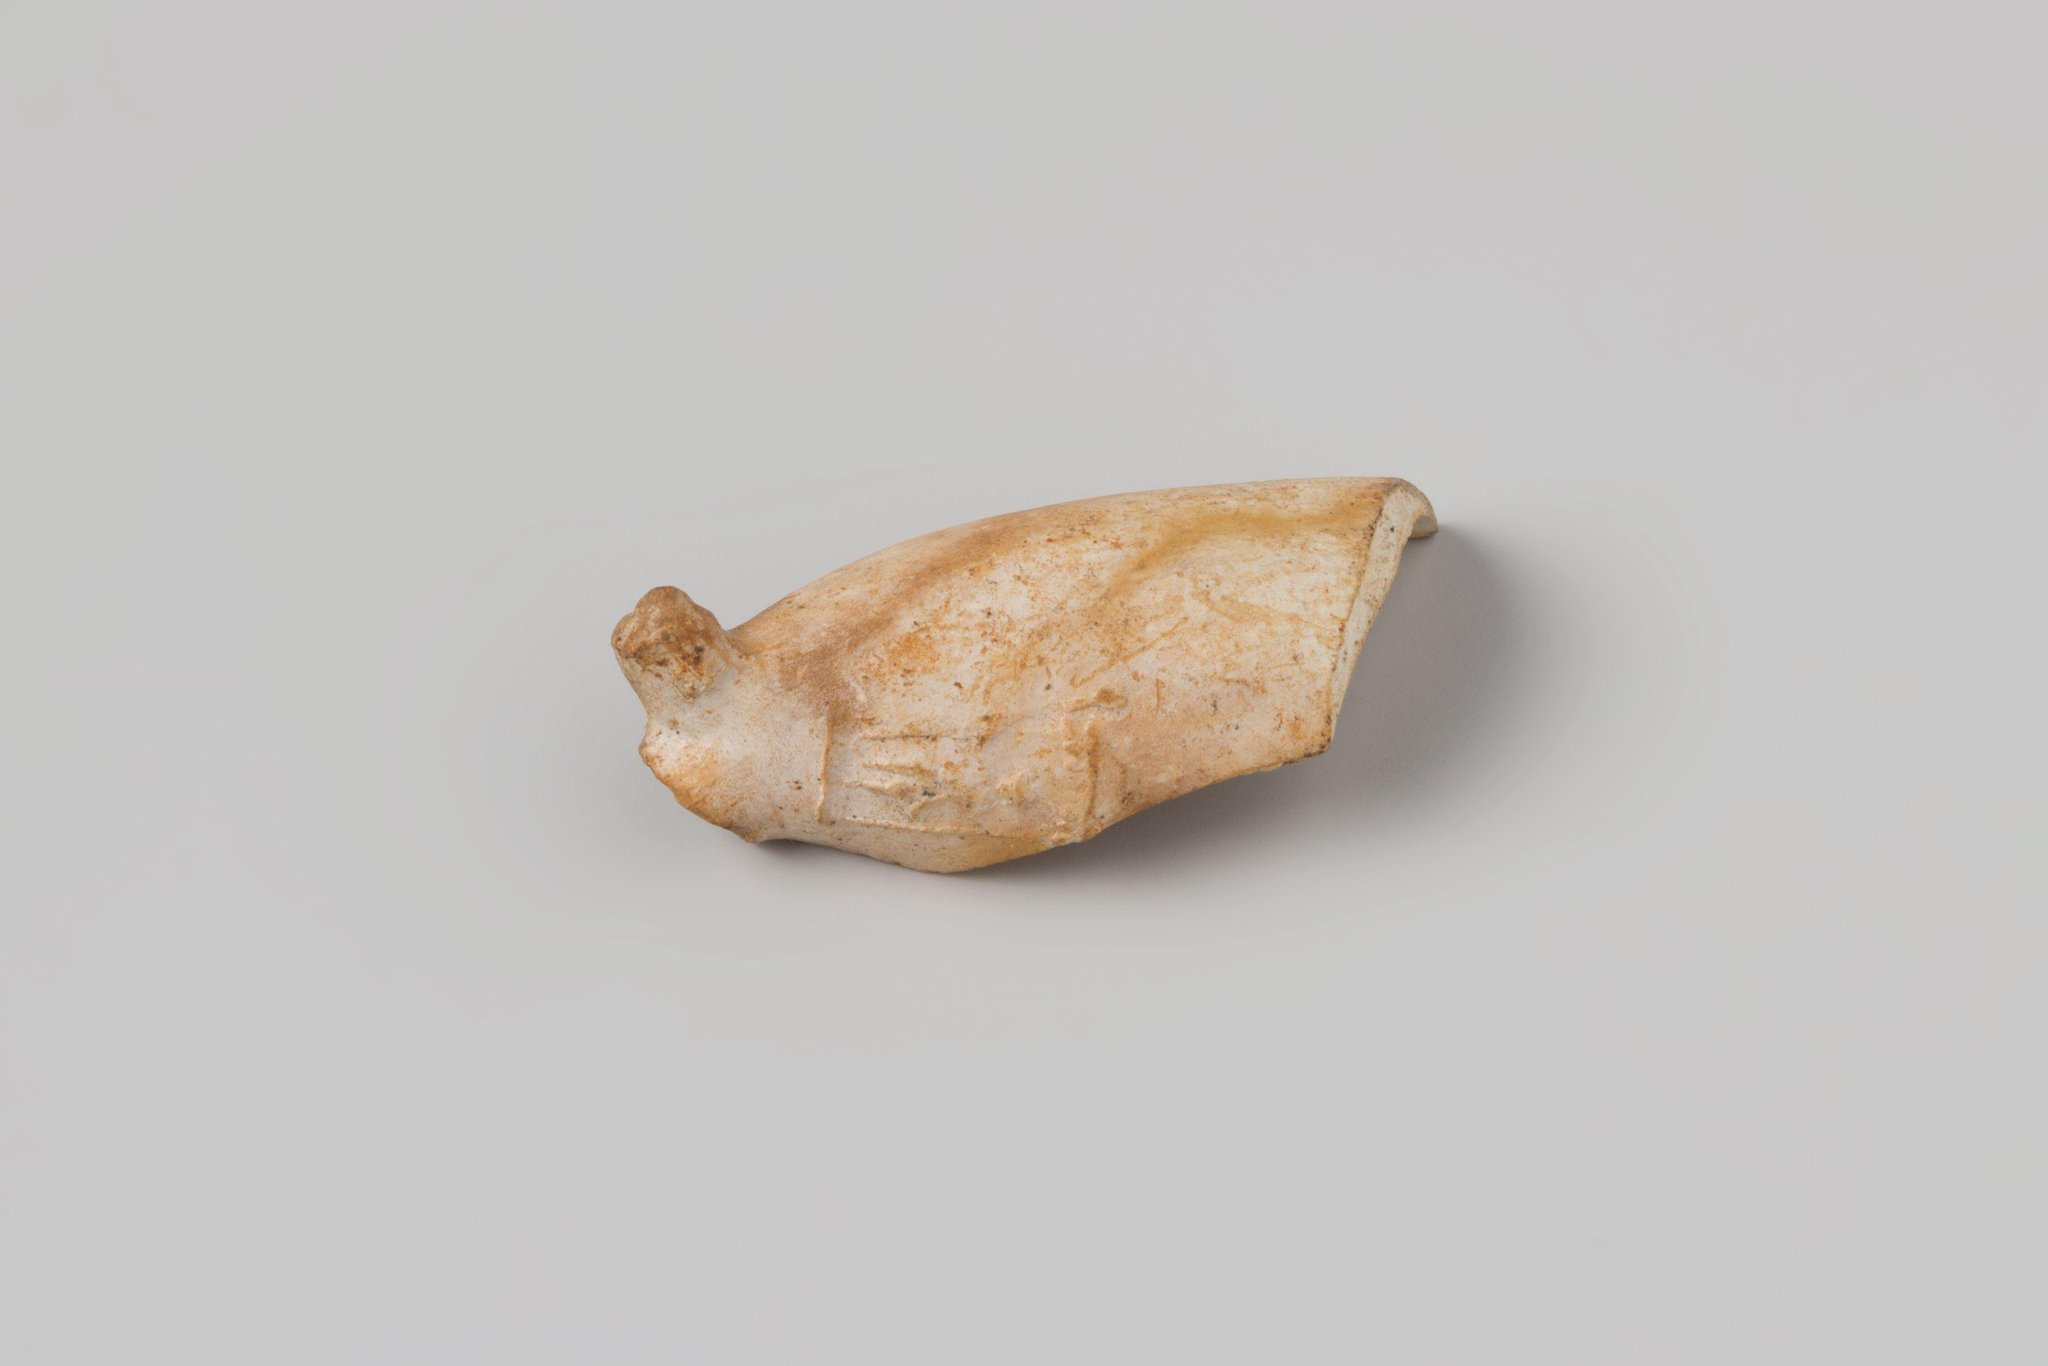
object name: pipe bowl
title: Fragment pijpenkop uit het wrak van de Oost-Indiëvaarder Hollandia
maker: Anonymous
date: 1700-1743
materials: clay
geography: netherlands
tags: verenigde oostindische compagnie, hollandia (schip), annet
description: Pipe, bowl, bowlmark: sentry; fragm, 2hsm1.